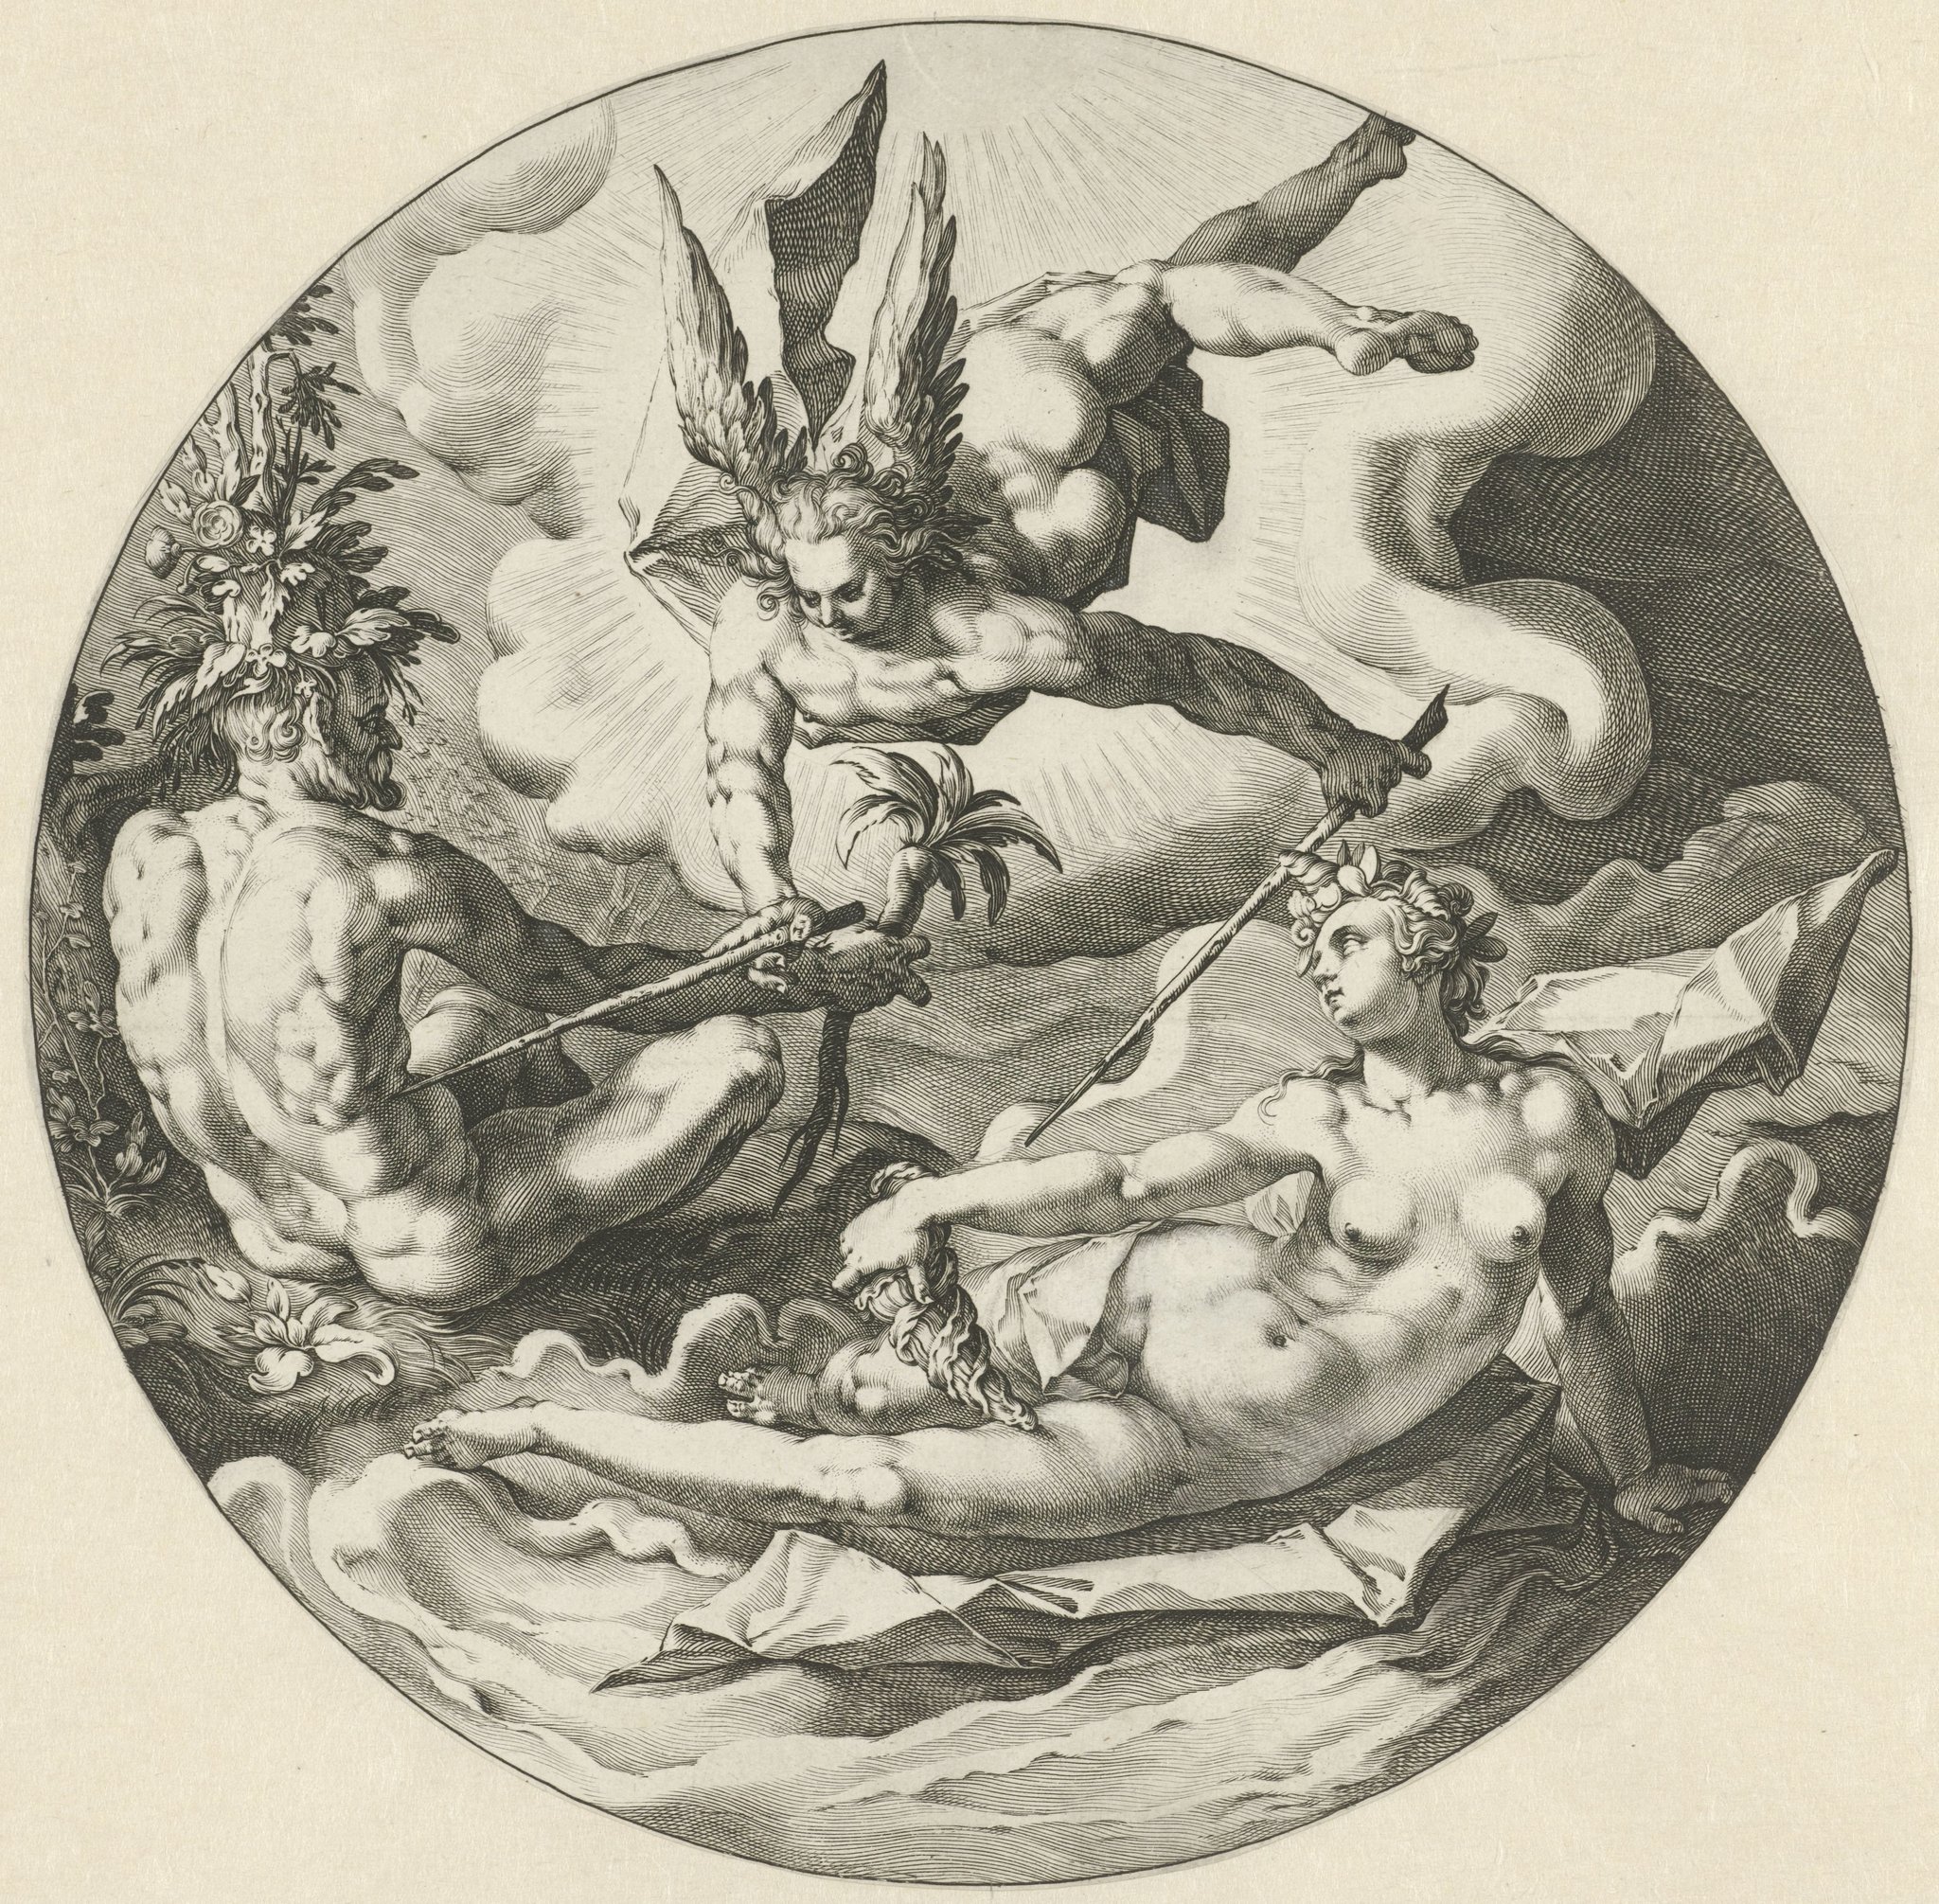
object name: print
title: Schepping van de wereld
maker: jan harmensz. muller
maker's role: draughtsman, print maker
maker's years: 1571-1628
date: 1589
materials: paper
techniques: engraving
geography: amsterdam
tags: gathering of the waters below the firmament; dry land appears and produces all kinds of plants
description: De derde scheppingsdag: een engel scheidt het land van het water van de zee. Het land wordt voorgesteld als een naakte man met een wortel in zijn hand en met een hoofdtooi van planten, bomen en bloemen. De zee wordt gepersonifieerd door een vrouw met schelp in de hand en schelpen in haar haren. Naar de Bijbeltekst in Gen. 1:9-13.